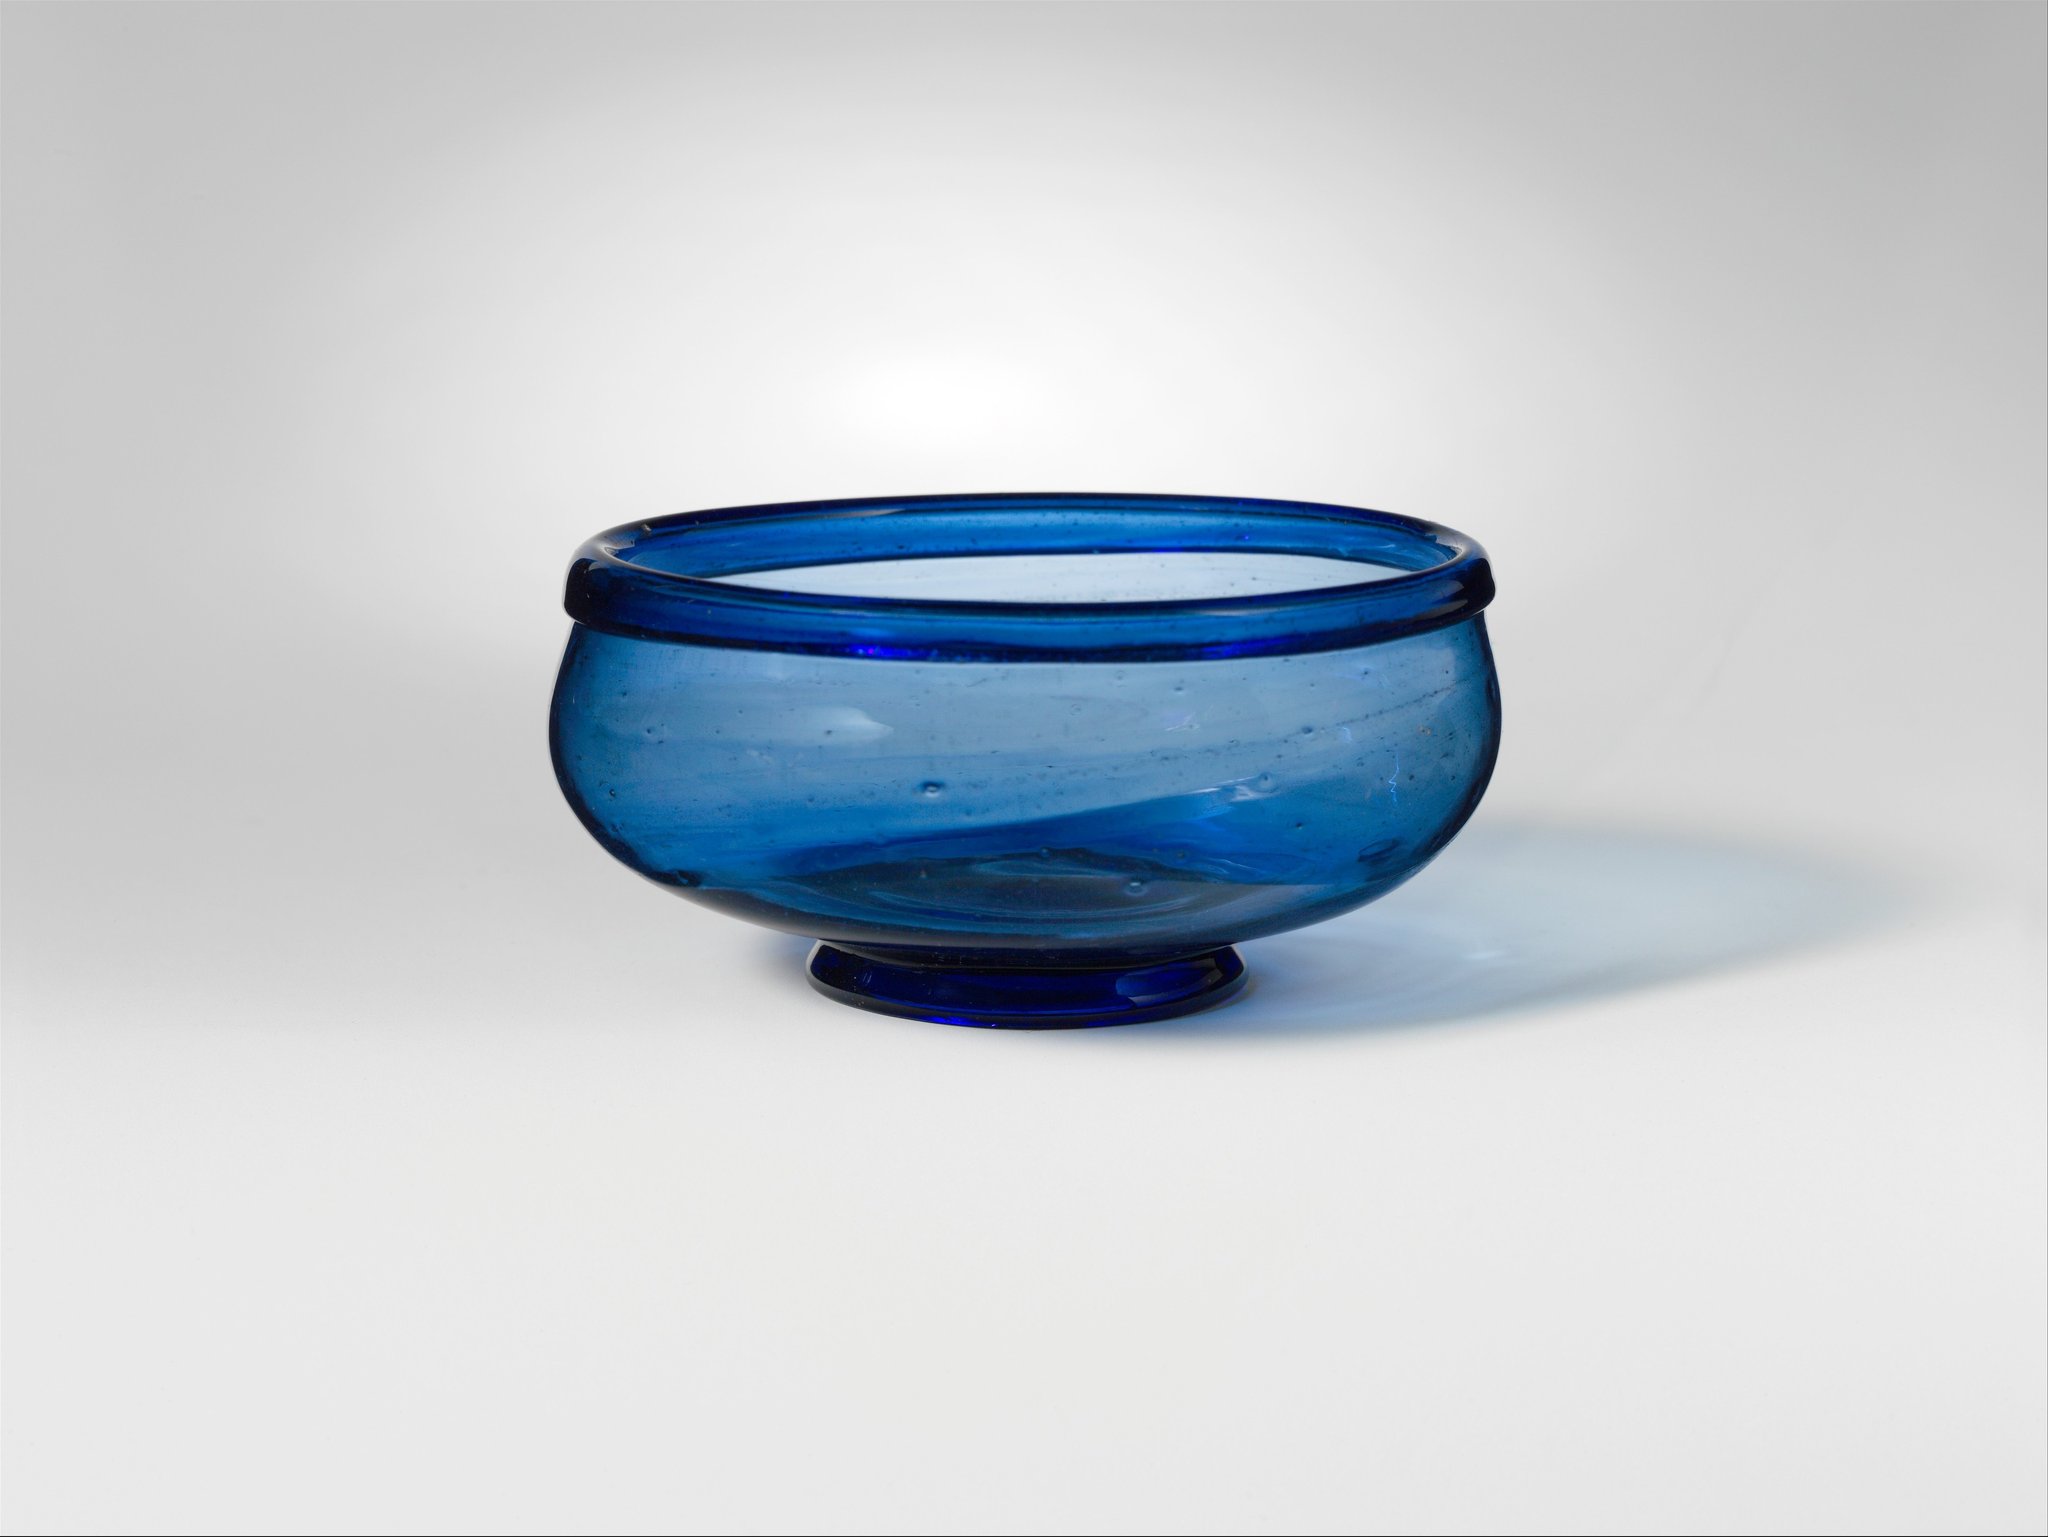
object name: bowl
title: Glass bowl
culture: roman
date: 51-100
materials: glass